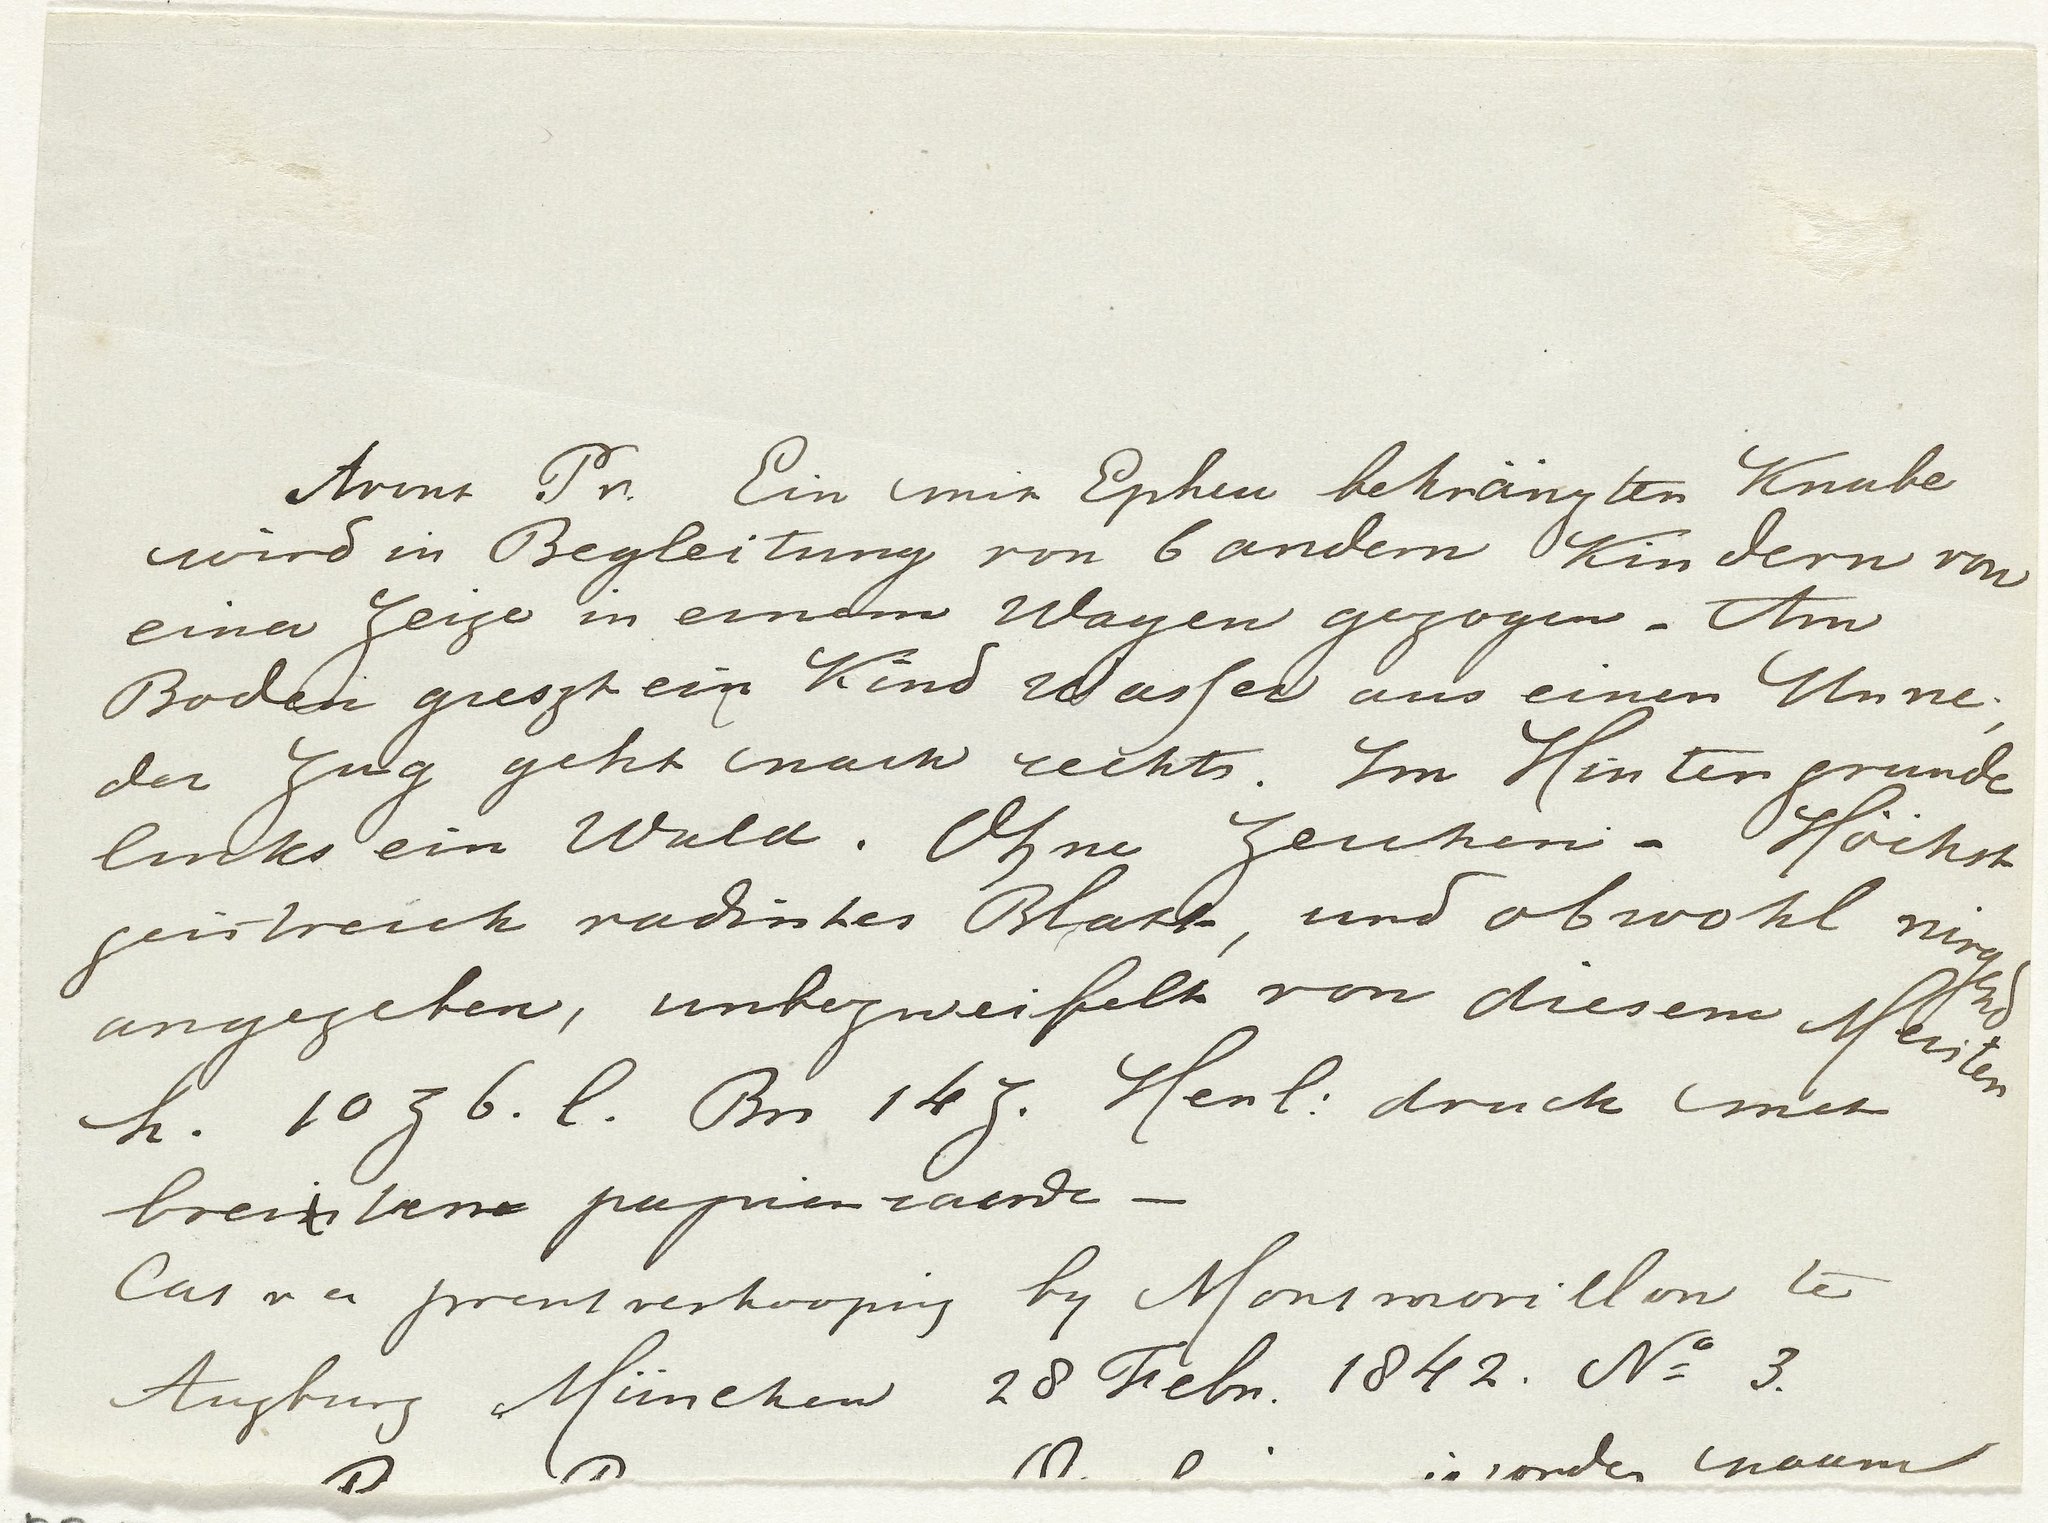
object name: print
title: Tekst bij putti met bokkenwagen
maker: Anonymous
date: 1842-1900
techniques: writing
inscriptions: collector's mark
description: Handgeschreven tekst in Duits, behorende bij putti met bokkenwagen van Johannes Gronsveld.